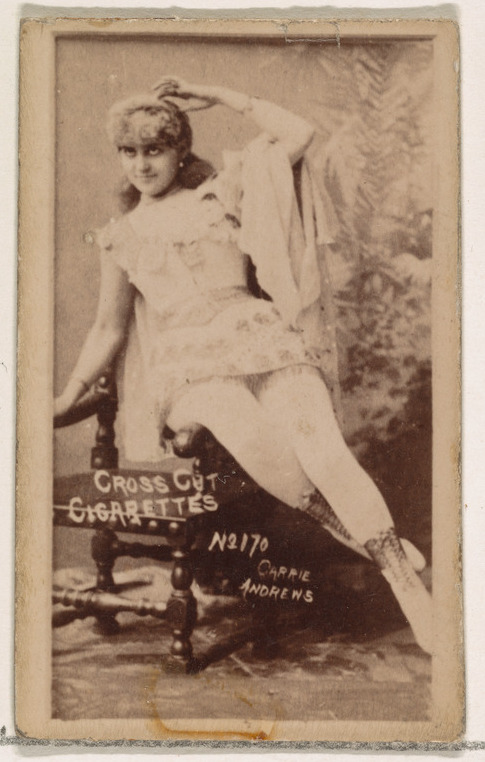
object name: print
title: Card Number 170, Carrie Andrews, from the Actors and Actresses series (N145-1) issued by Duke Sons & Co. to promote Cross Cut Cigarettes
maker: w. duke, sons & co.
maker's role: publisher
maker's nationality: american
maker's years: 1870-1920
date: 1880-1889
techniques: albumen silver print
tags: portraits,women,actresses